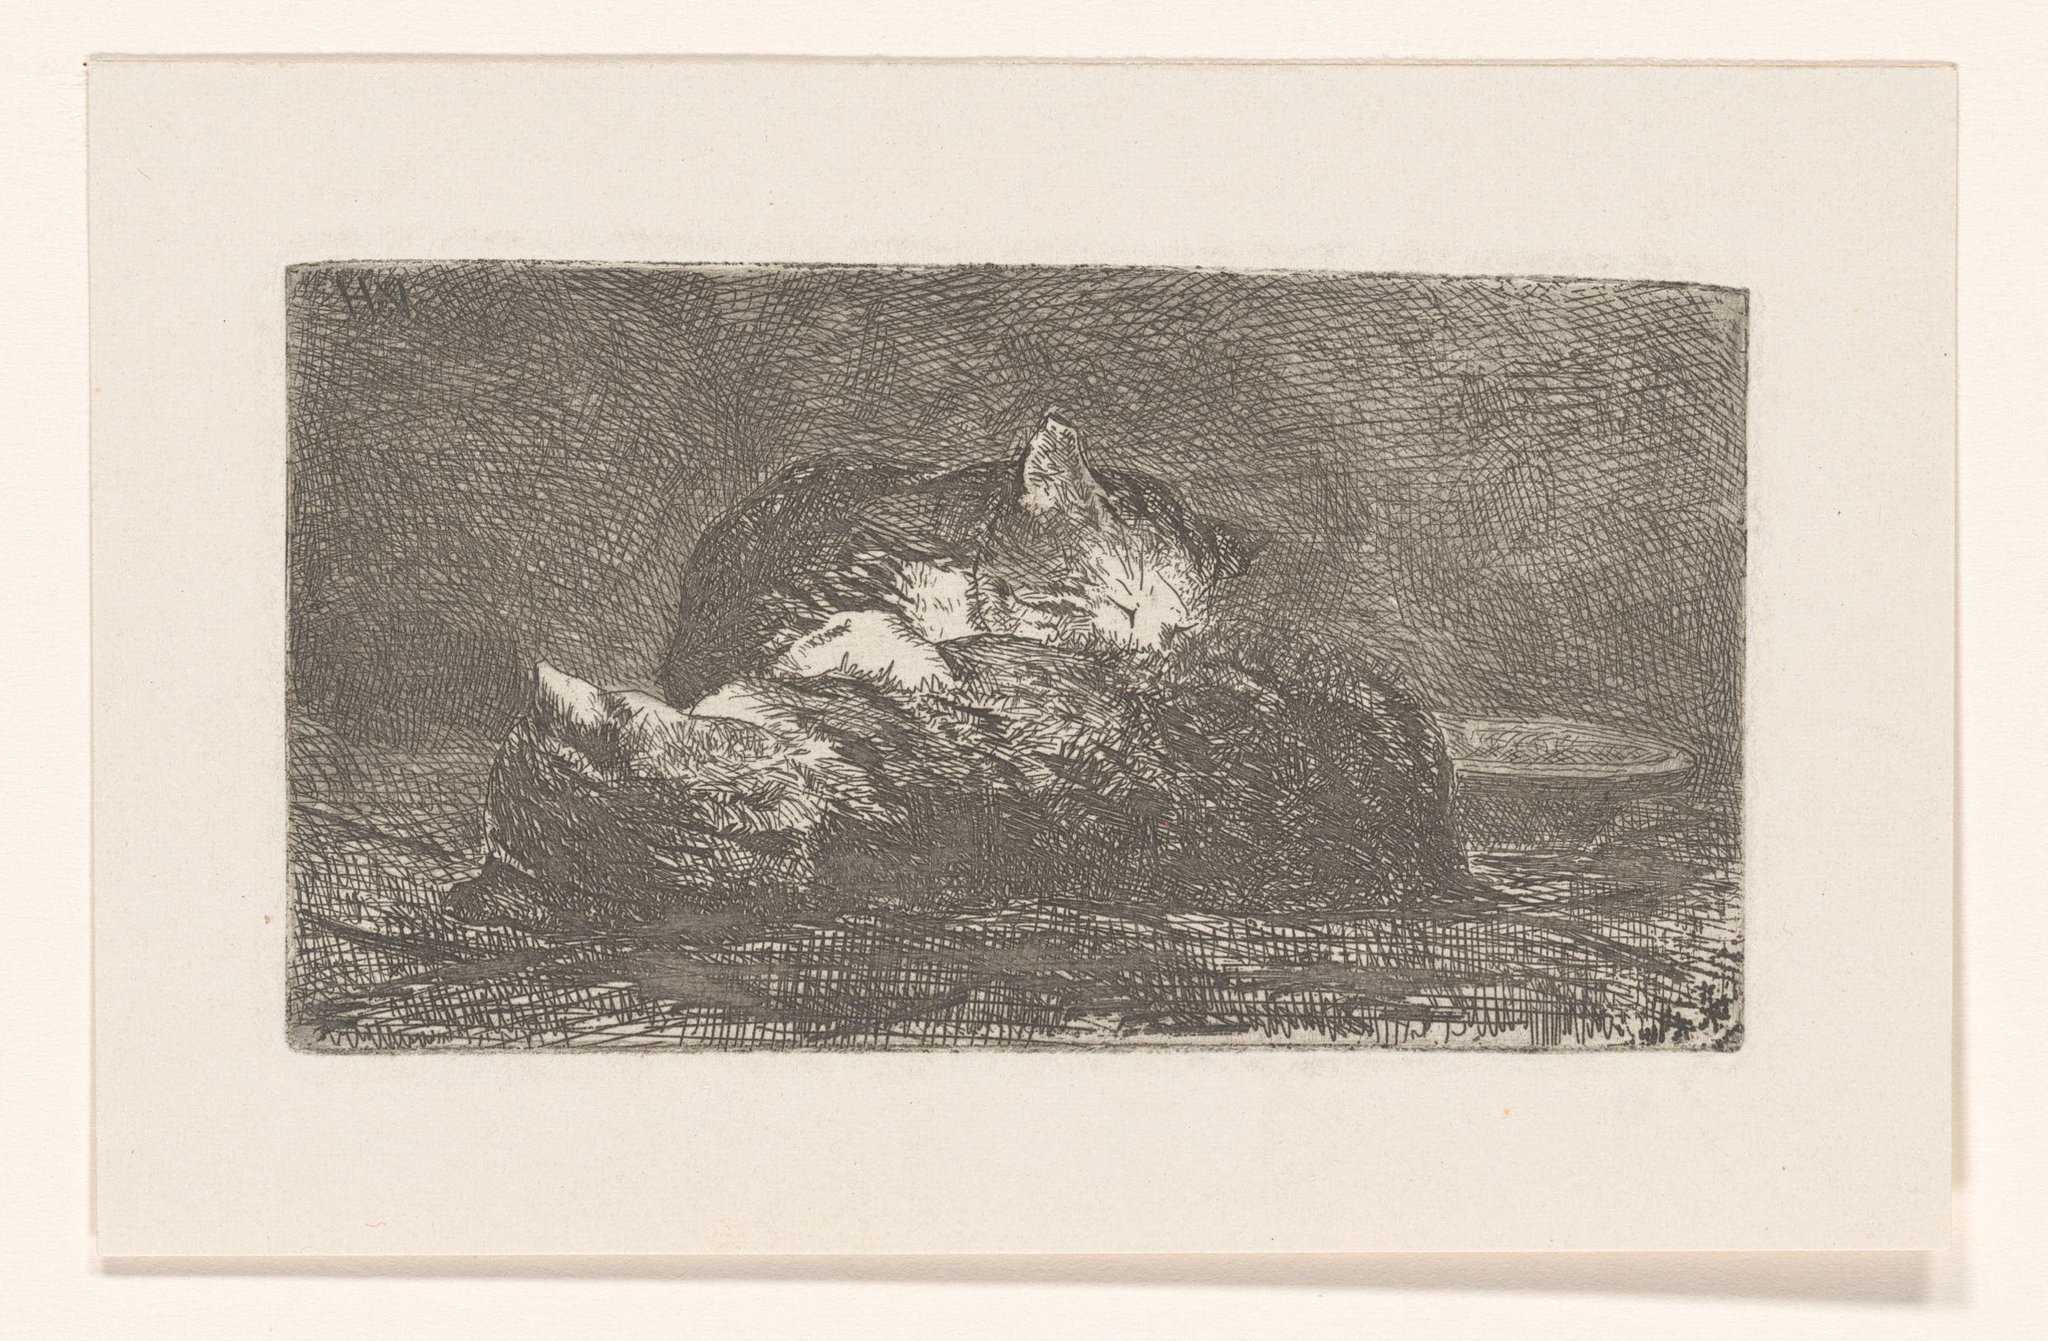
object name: print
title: Twee katten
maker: herman johannes van der weele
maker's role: print maker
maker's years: 1852-1930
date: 1862-1887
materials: paper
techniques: etching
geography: netherlands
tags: cat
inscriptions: collector's mark: Lugt 2228, inscription: ‘1e druk’